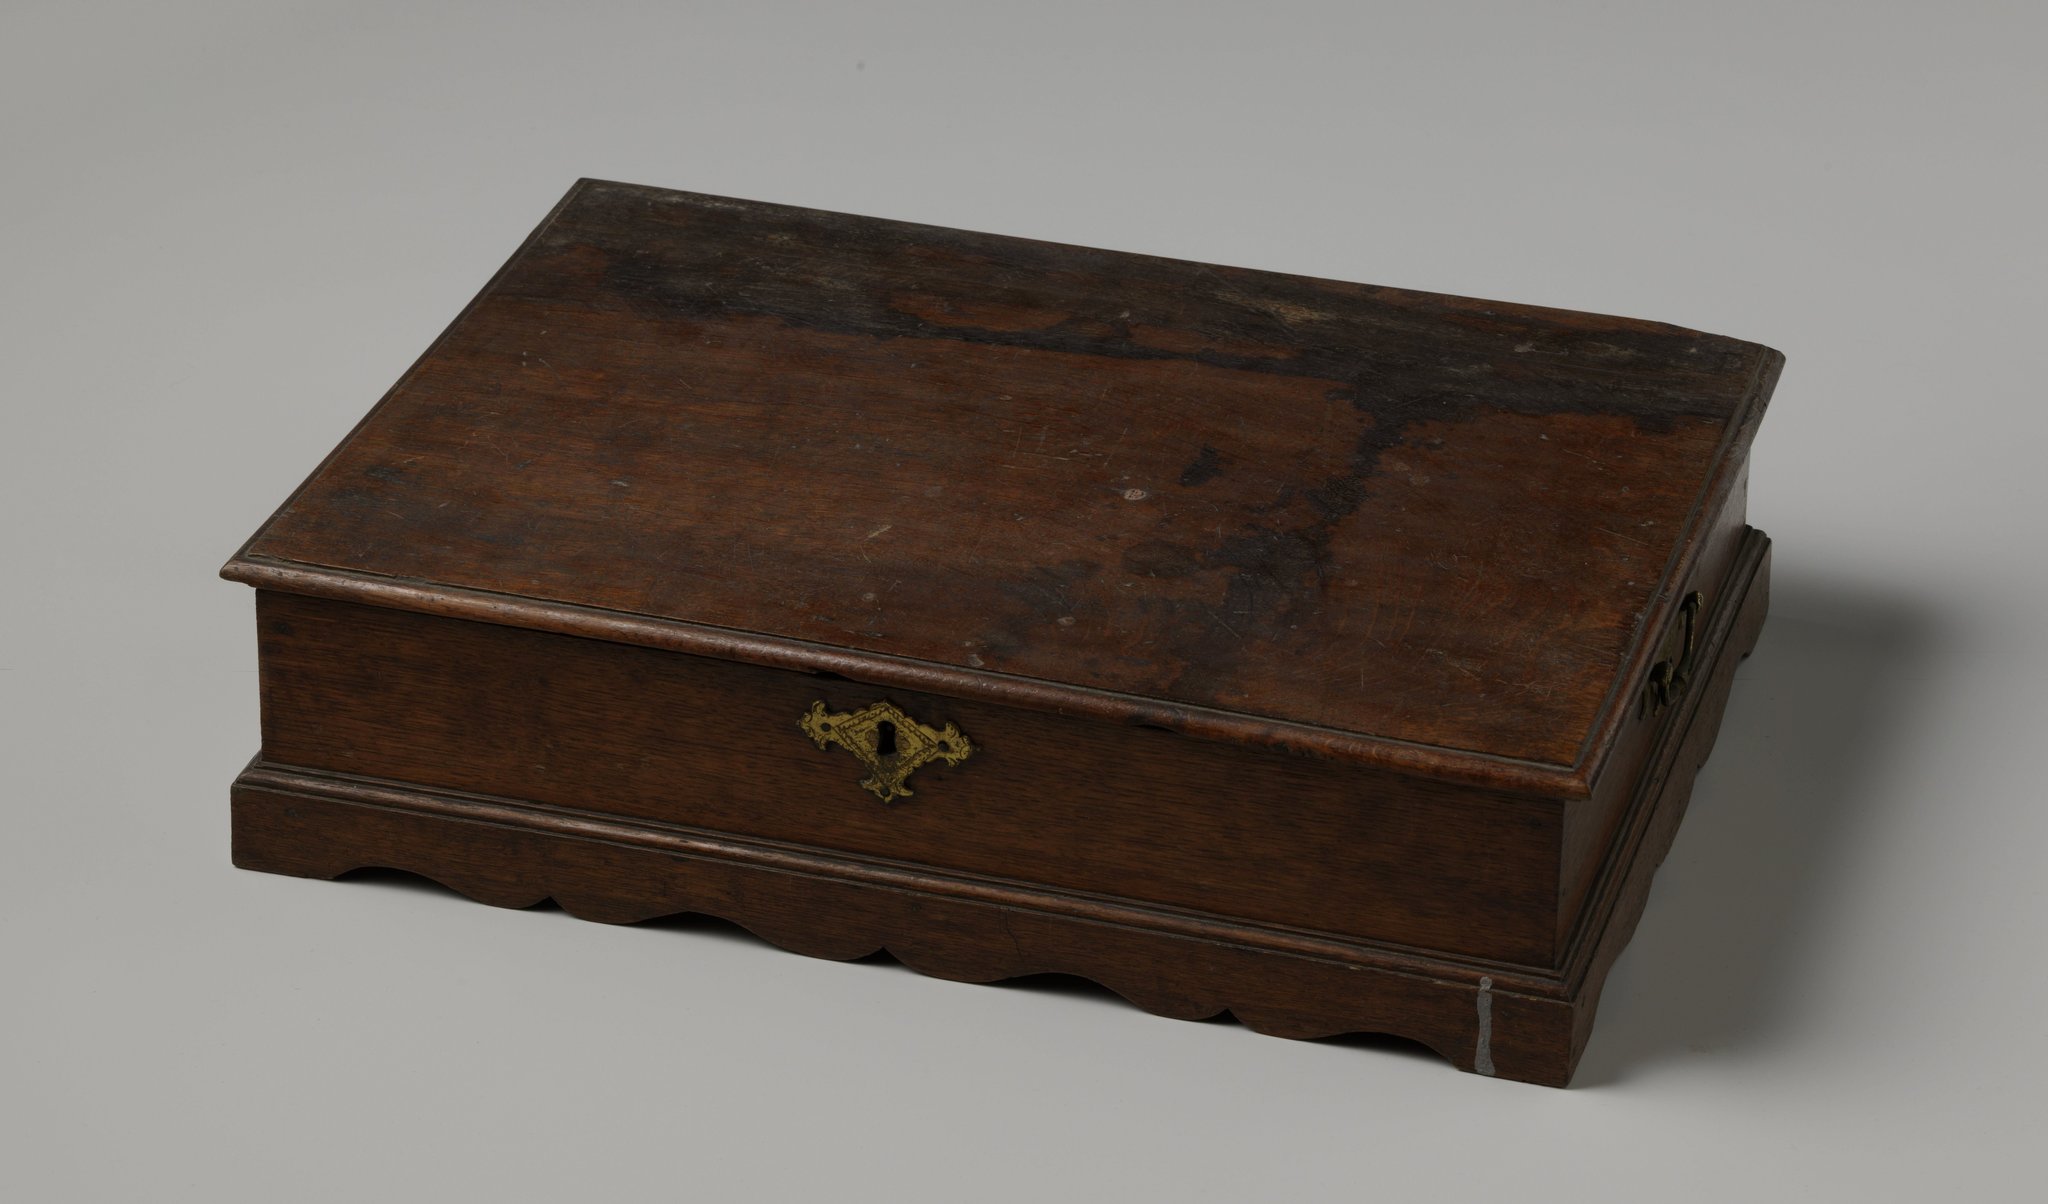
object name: chest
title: Kist van hout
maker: Anonymous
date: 1760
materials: copper alloy, wood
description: Behorend bij 29 toverlantaarnplaatjes in houten frame met (vijf) ronde glasplaten gebruikt voor toverlantaarn.